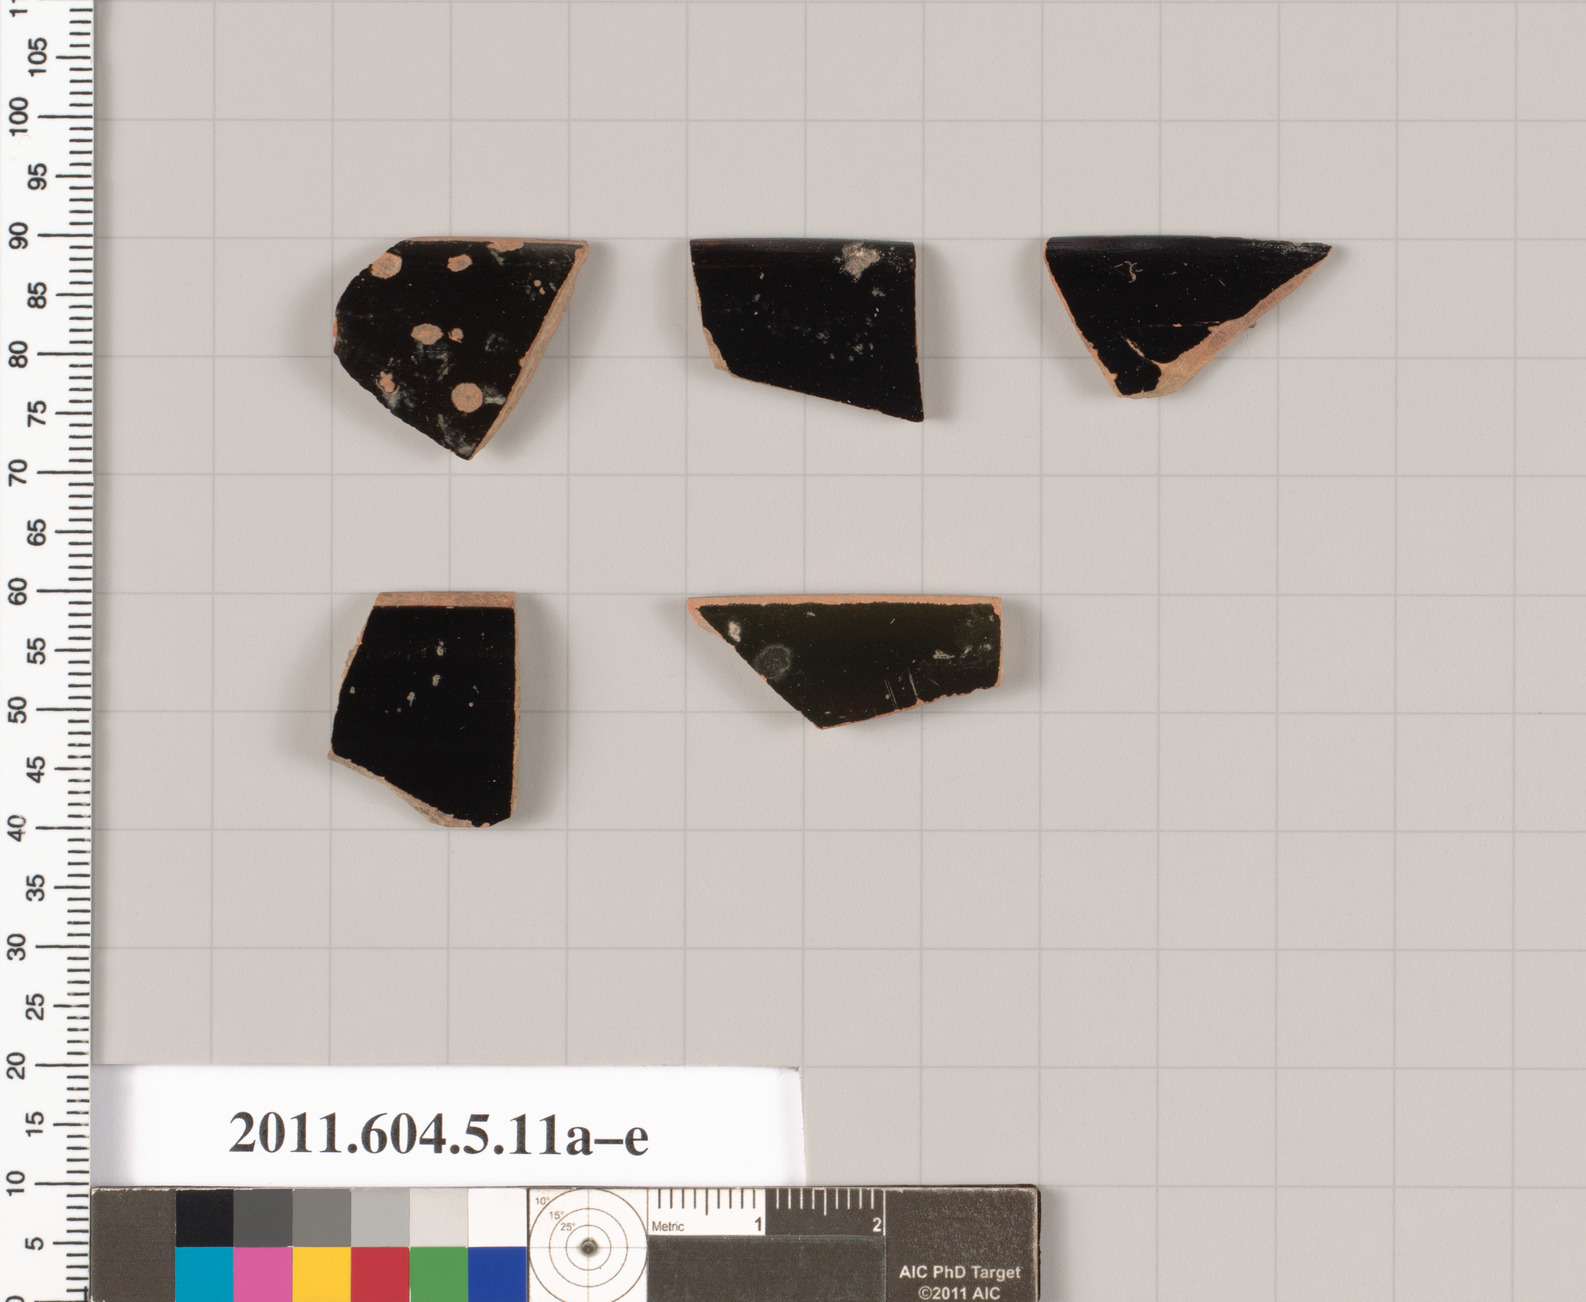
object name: kylix fragment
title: Terracotta rim fragments of kylikes (drinking cups)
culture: greek, attic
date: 475-451 BCE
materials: terracotta